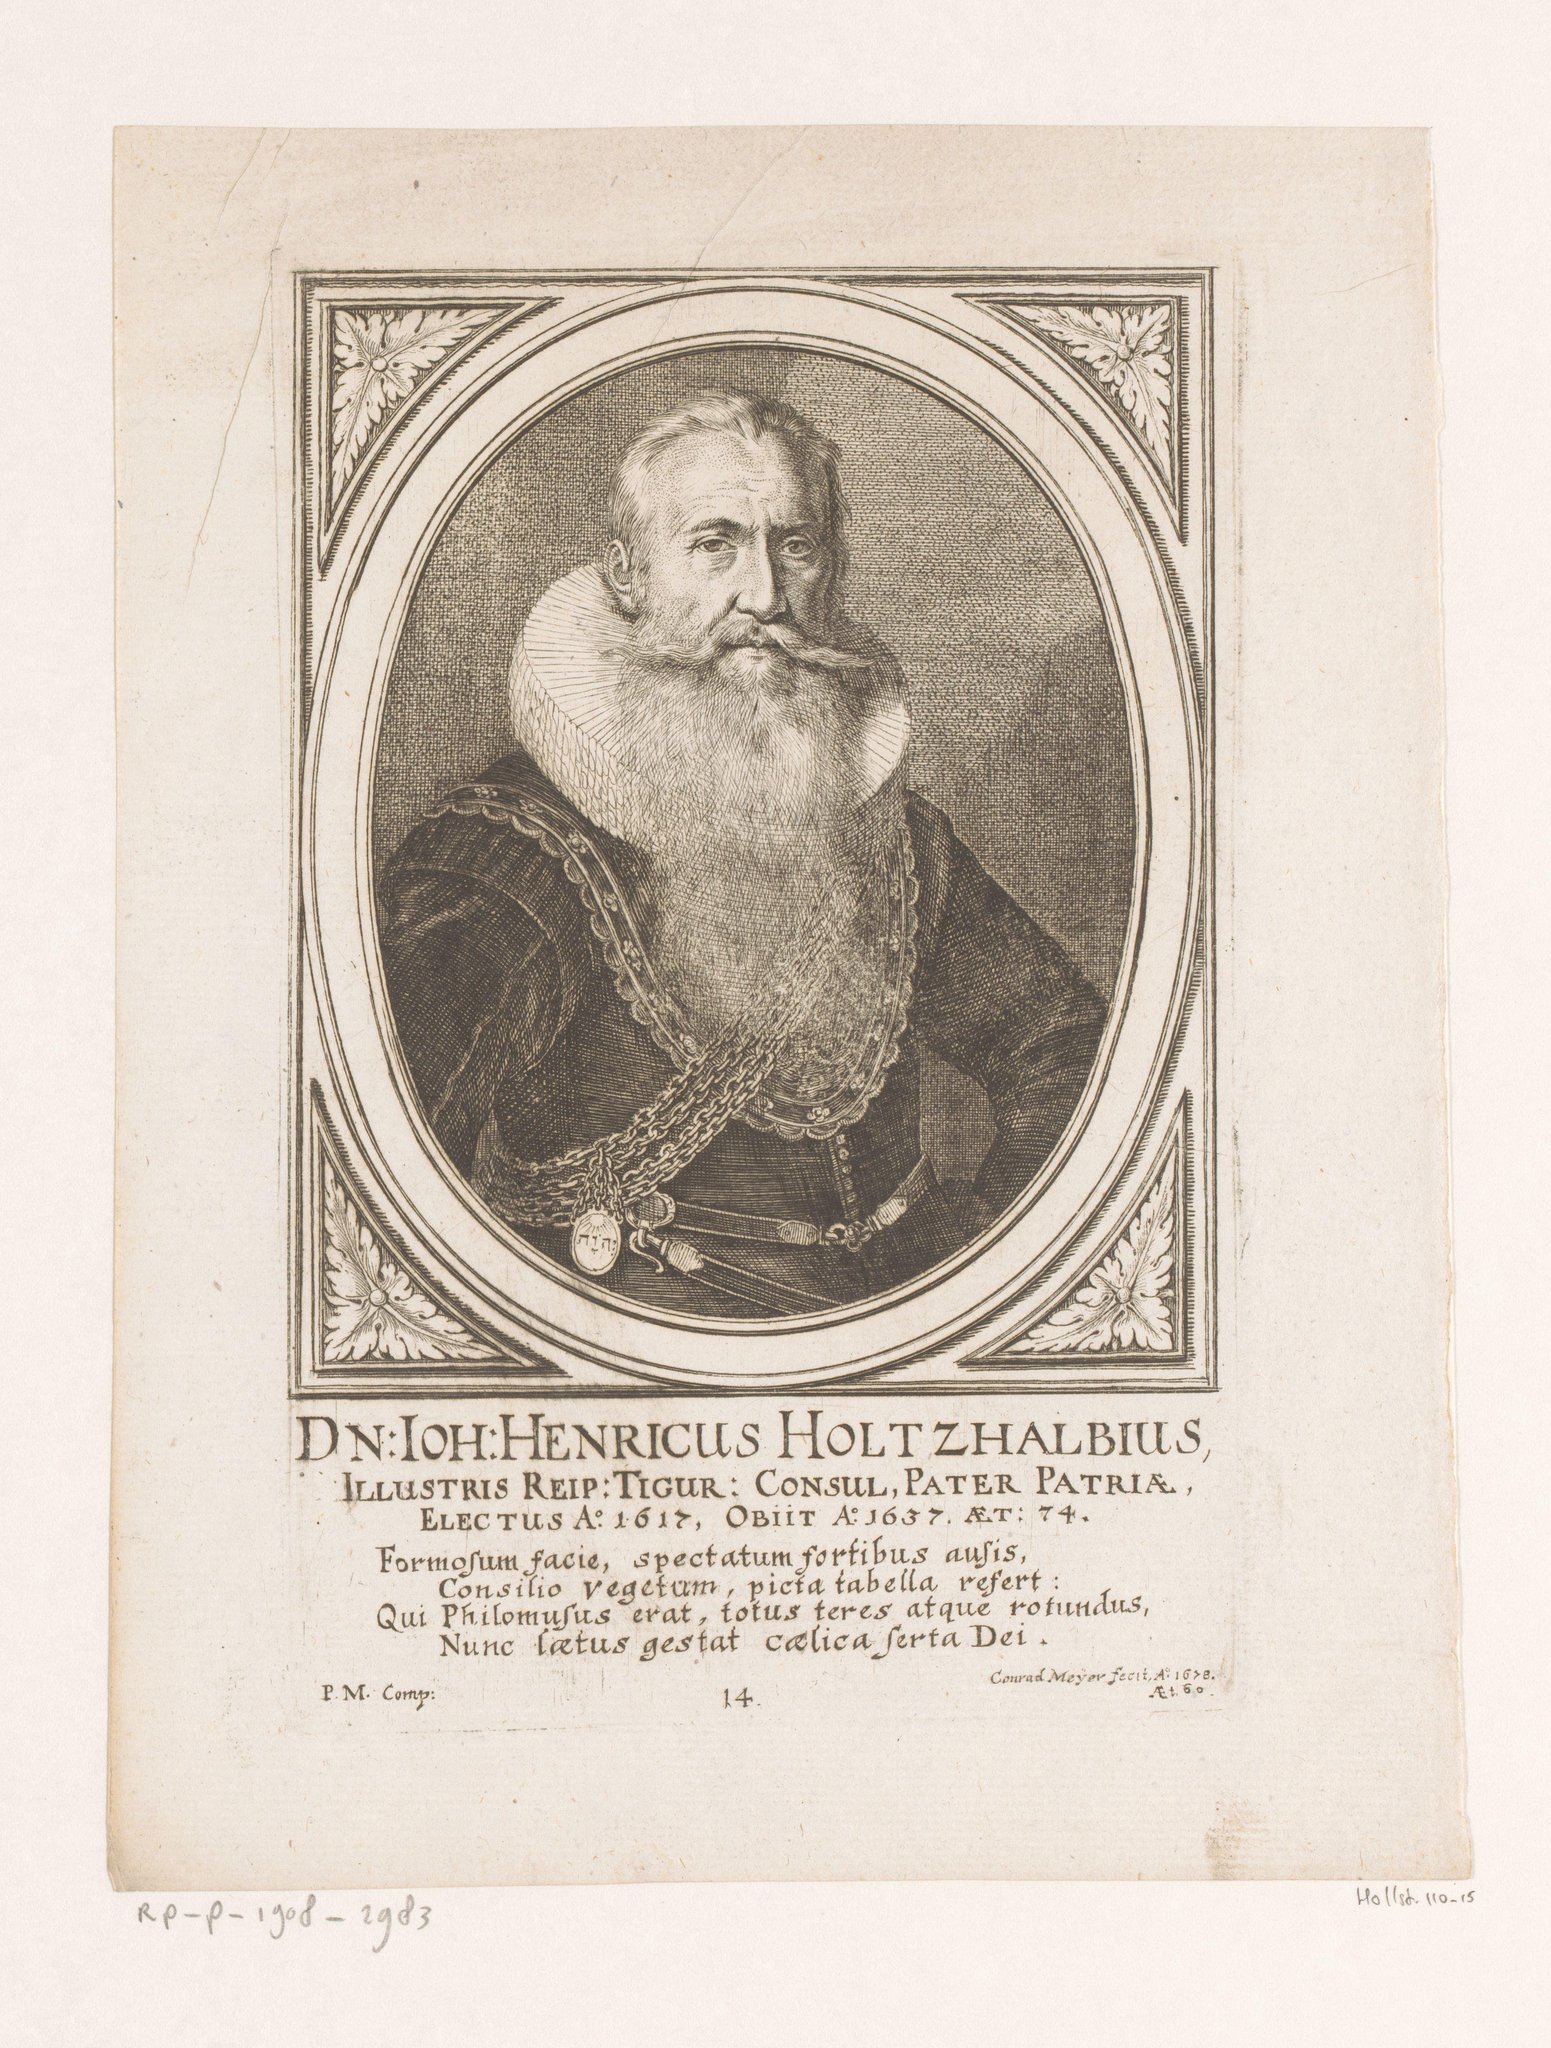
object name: print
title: Portretten van burgemeesters van Zürich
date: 1678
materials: paper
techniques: engraving, etching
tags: mayor, burgomaster, other non-personal regalia, e.g. mayor chain, historical persons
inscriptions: collector's mark: Lugt 2228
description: Onderdeel van een serie van 67(?) portretten van burgemeesters van Zürich. Zie Hollstein German 110, 1-26.